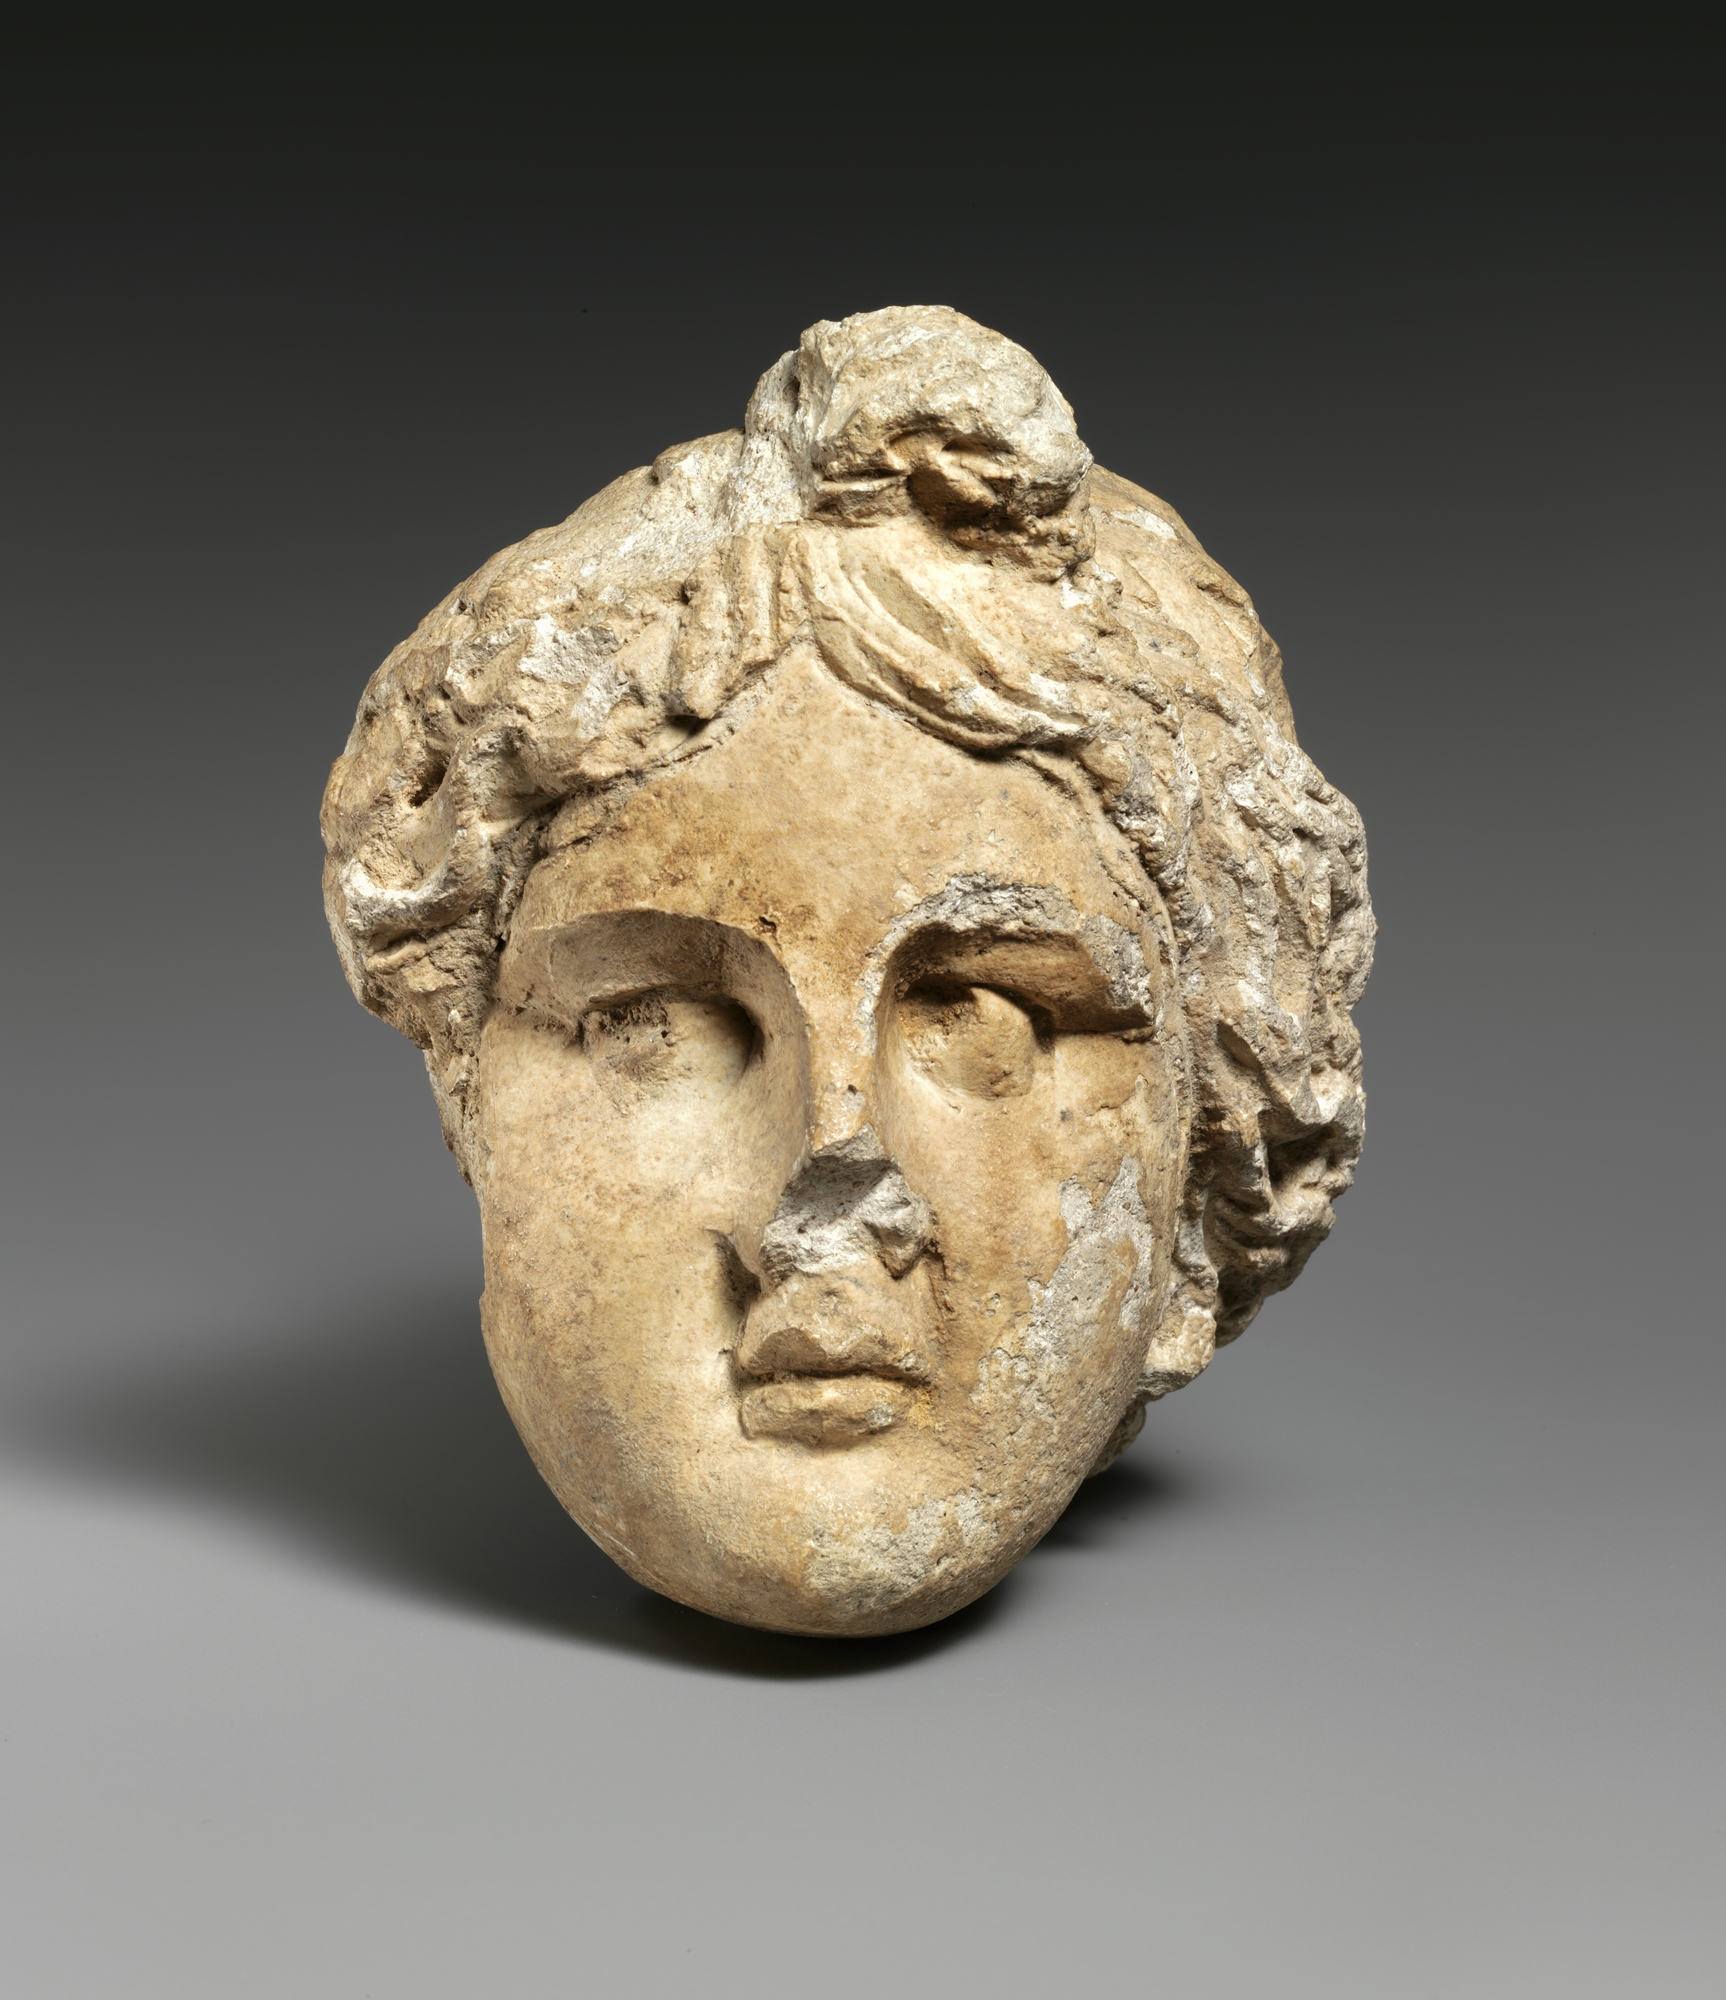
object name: head of a woman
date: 7000 BCE-330 CE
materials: limestone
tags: heads,women